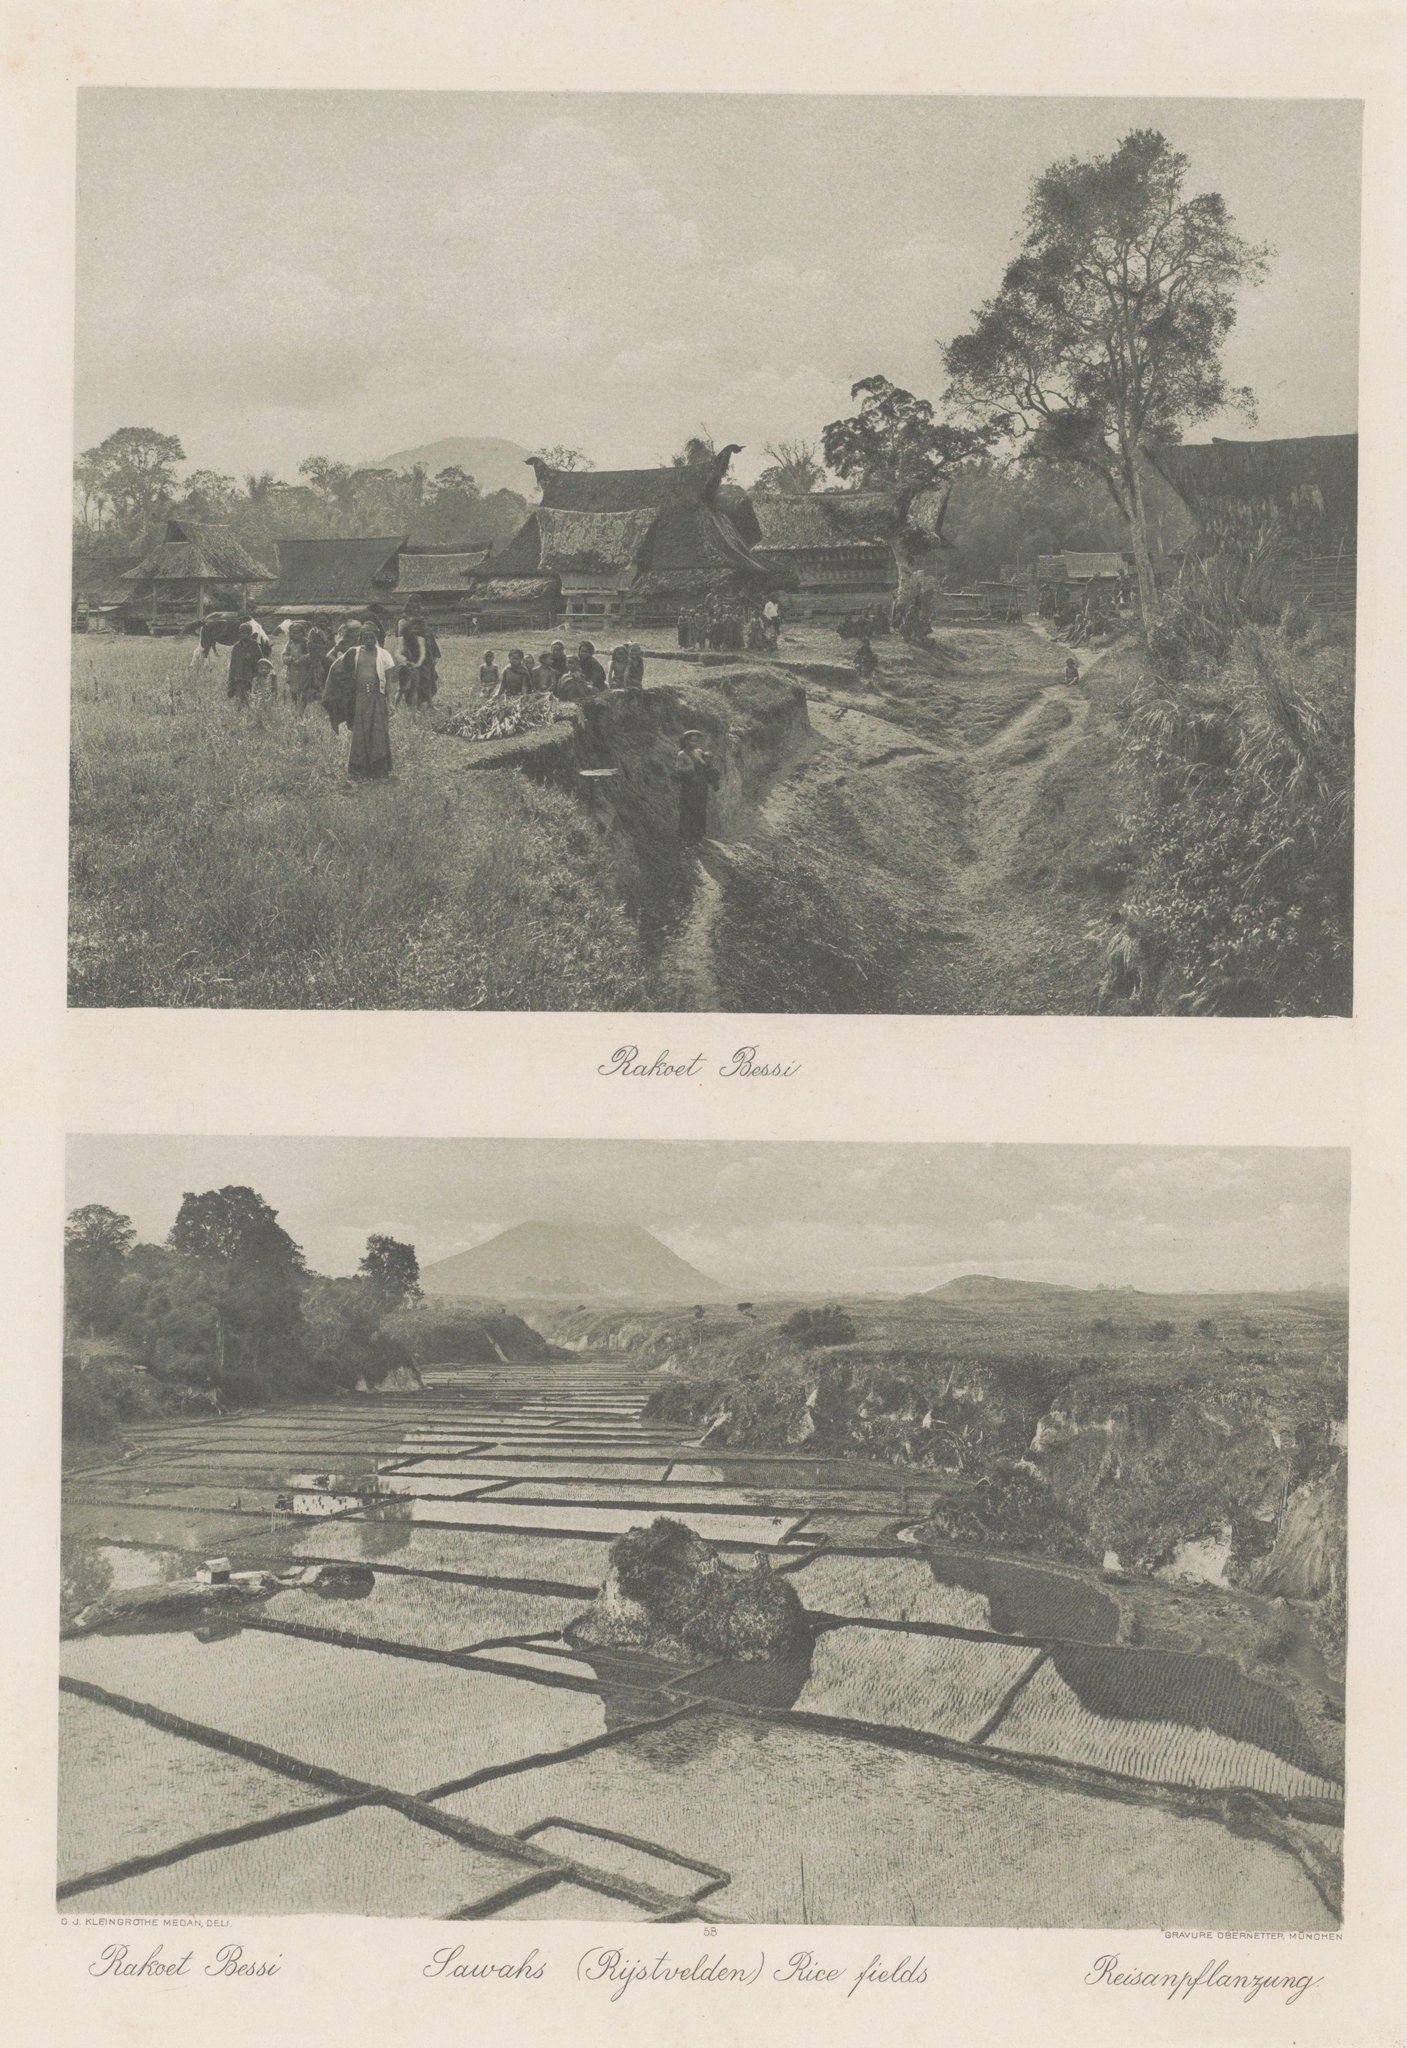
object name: photomechanical print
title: Rakoet Bessi (boven), Sawahs (Rijstvelden) (onder)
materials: paper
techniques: photoaquatint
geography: sumatra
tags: prospect of village, silhouette of village, sawahs, rice paddies, volcano, sumatra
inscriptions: number: ‘58’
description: Onderdeel van Album met heliogravures van Sumatra's oostkust.